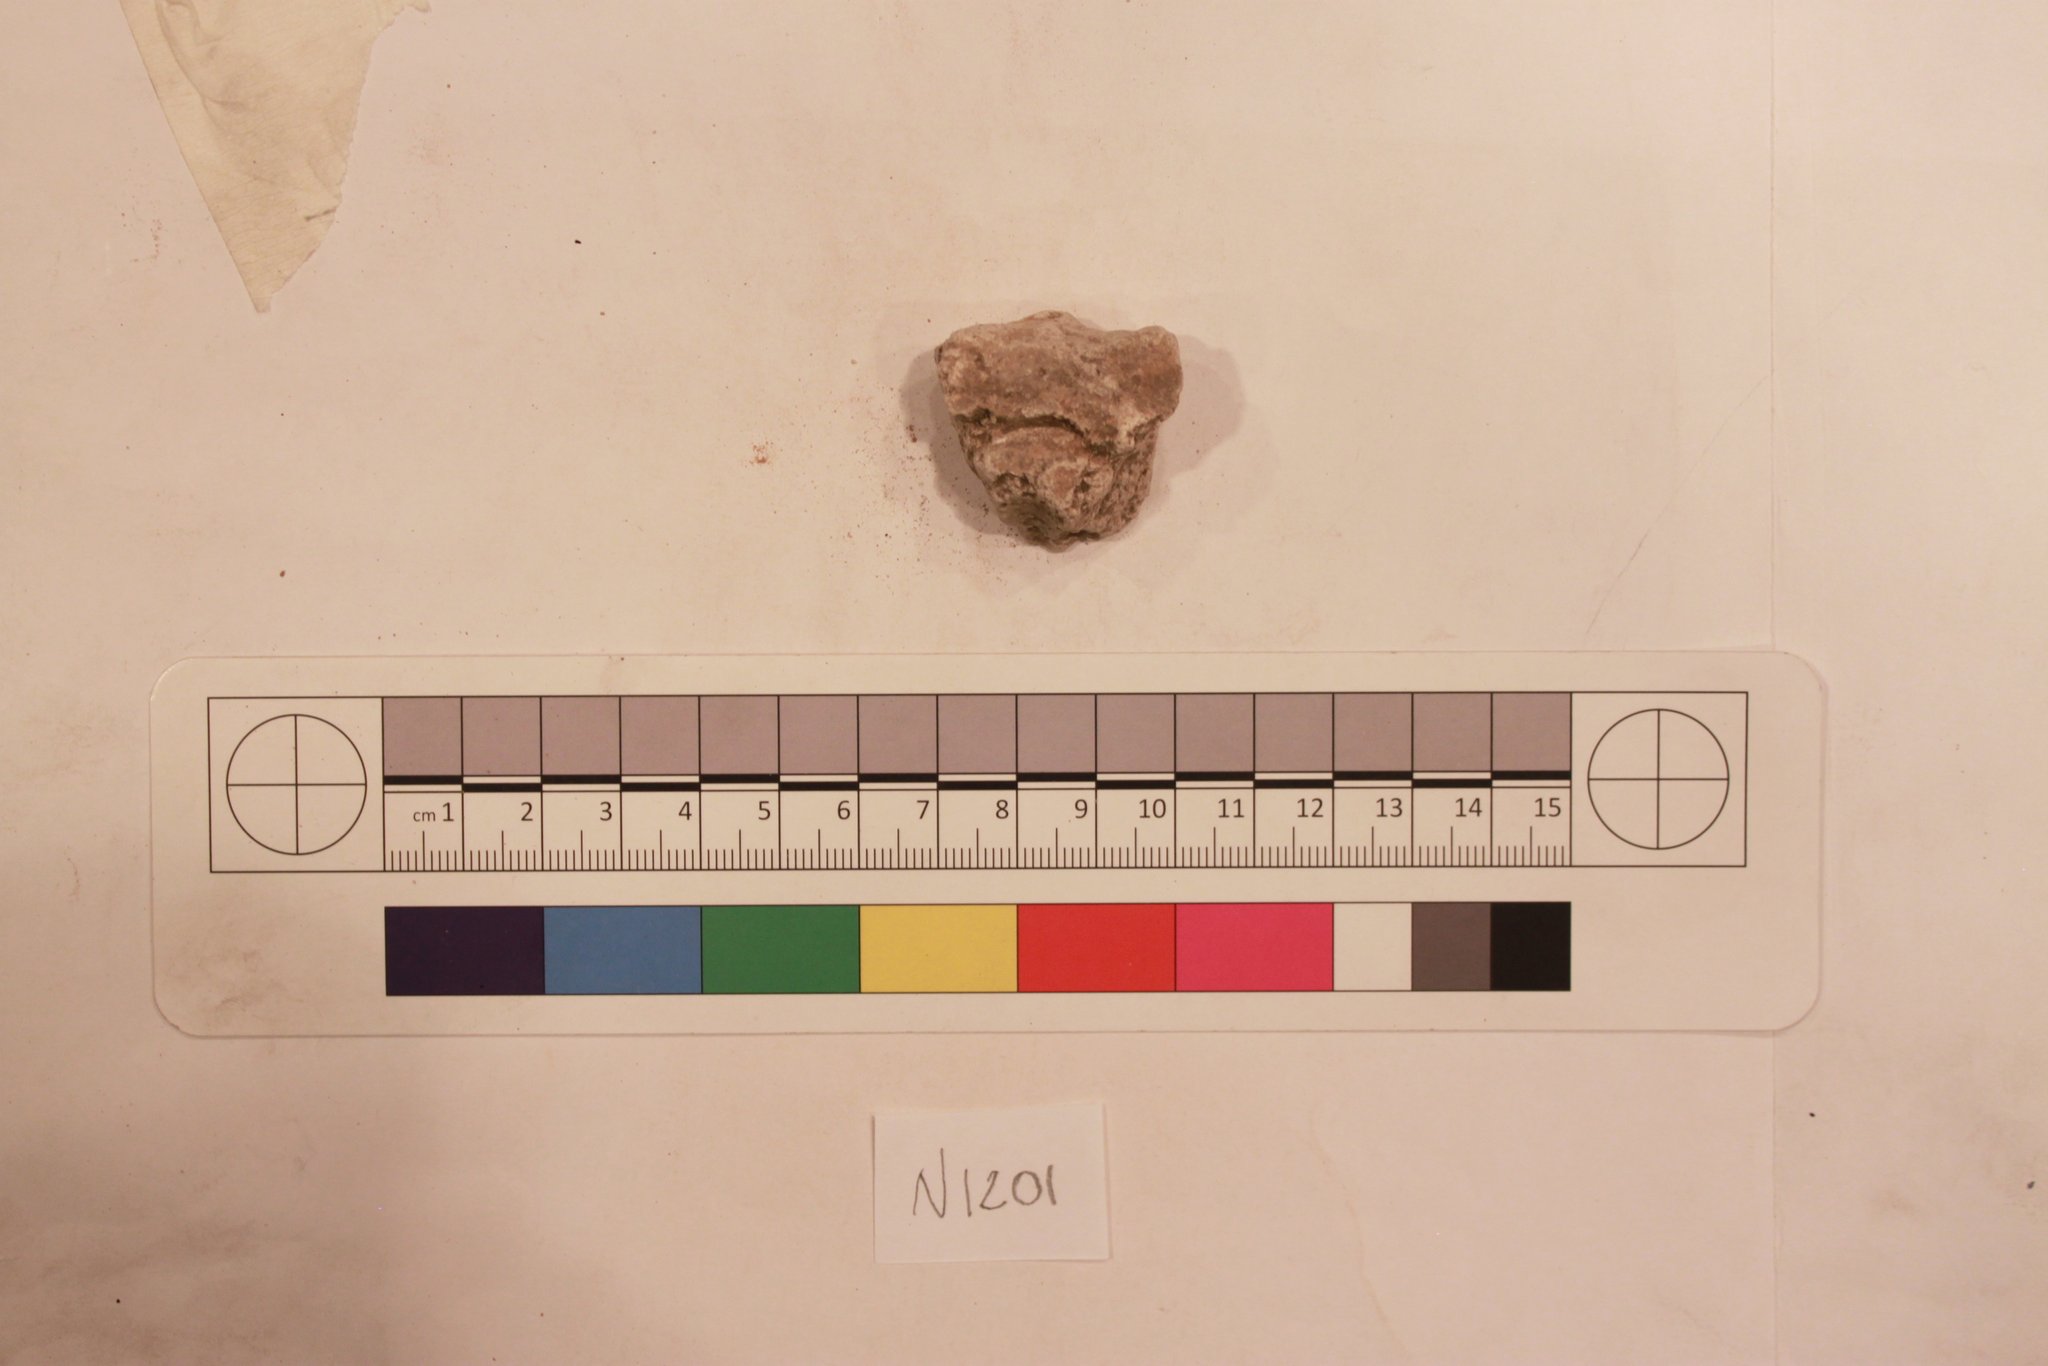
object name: fragment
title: Stucco Fragment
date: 701-1200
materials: plaster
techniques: carving, painting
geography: iran